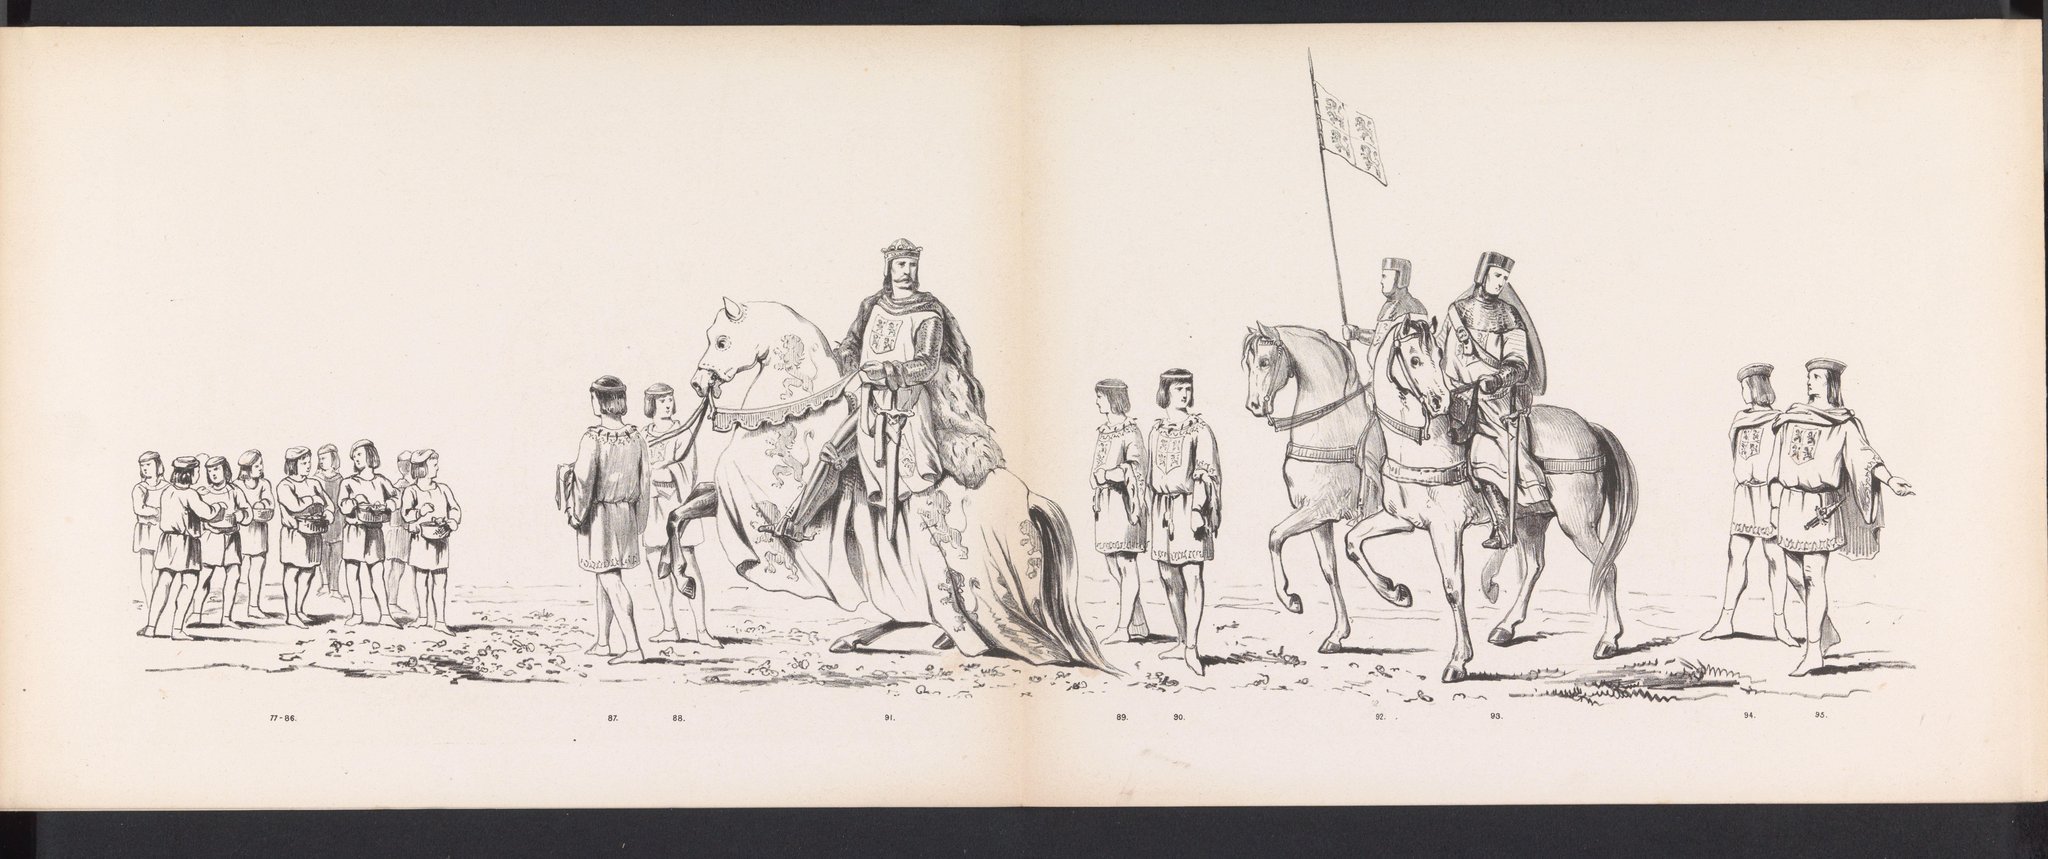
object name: print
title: Gecostumeerde optogt gehouden door de leden van het Leidsche studenten-corps den 6den Junij 1865, ter viering van den 290sten verjaardag der Leidsche Hoogeschool, voorstellende: de intogt der Hollanders binnen Zierikzee onder Jonker Willem, Grave van Oostervant, op den 12den augustus Anno 1304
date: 1865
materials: paper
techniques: lithograph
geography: netherlands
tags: students' pageant, costumes used in pageants, leiden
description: Historische gekostumeerde optocht van de studenten van de Leidse Hogeschool gehouden op 6 juni 1865 ter gelegenheid van het 290-jarig bestaan van de Hogeschool. De optocht verbeeldt de intocht van de Hollanders binnen Zierikzee op 12 augustus 1304. Zevende plaat met de groepen genummerd 77-95. Onderdeel van de serie van 16 aaneen geplakte bladen.